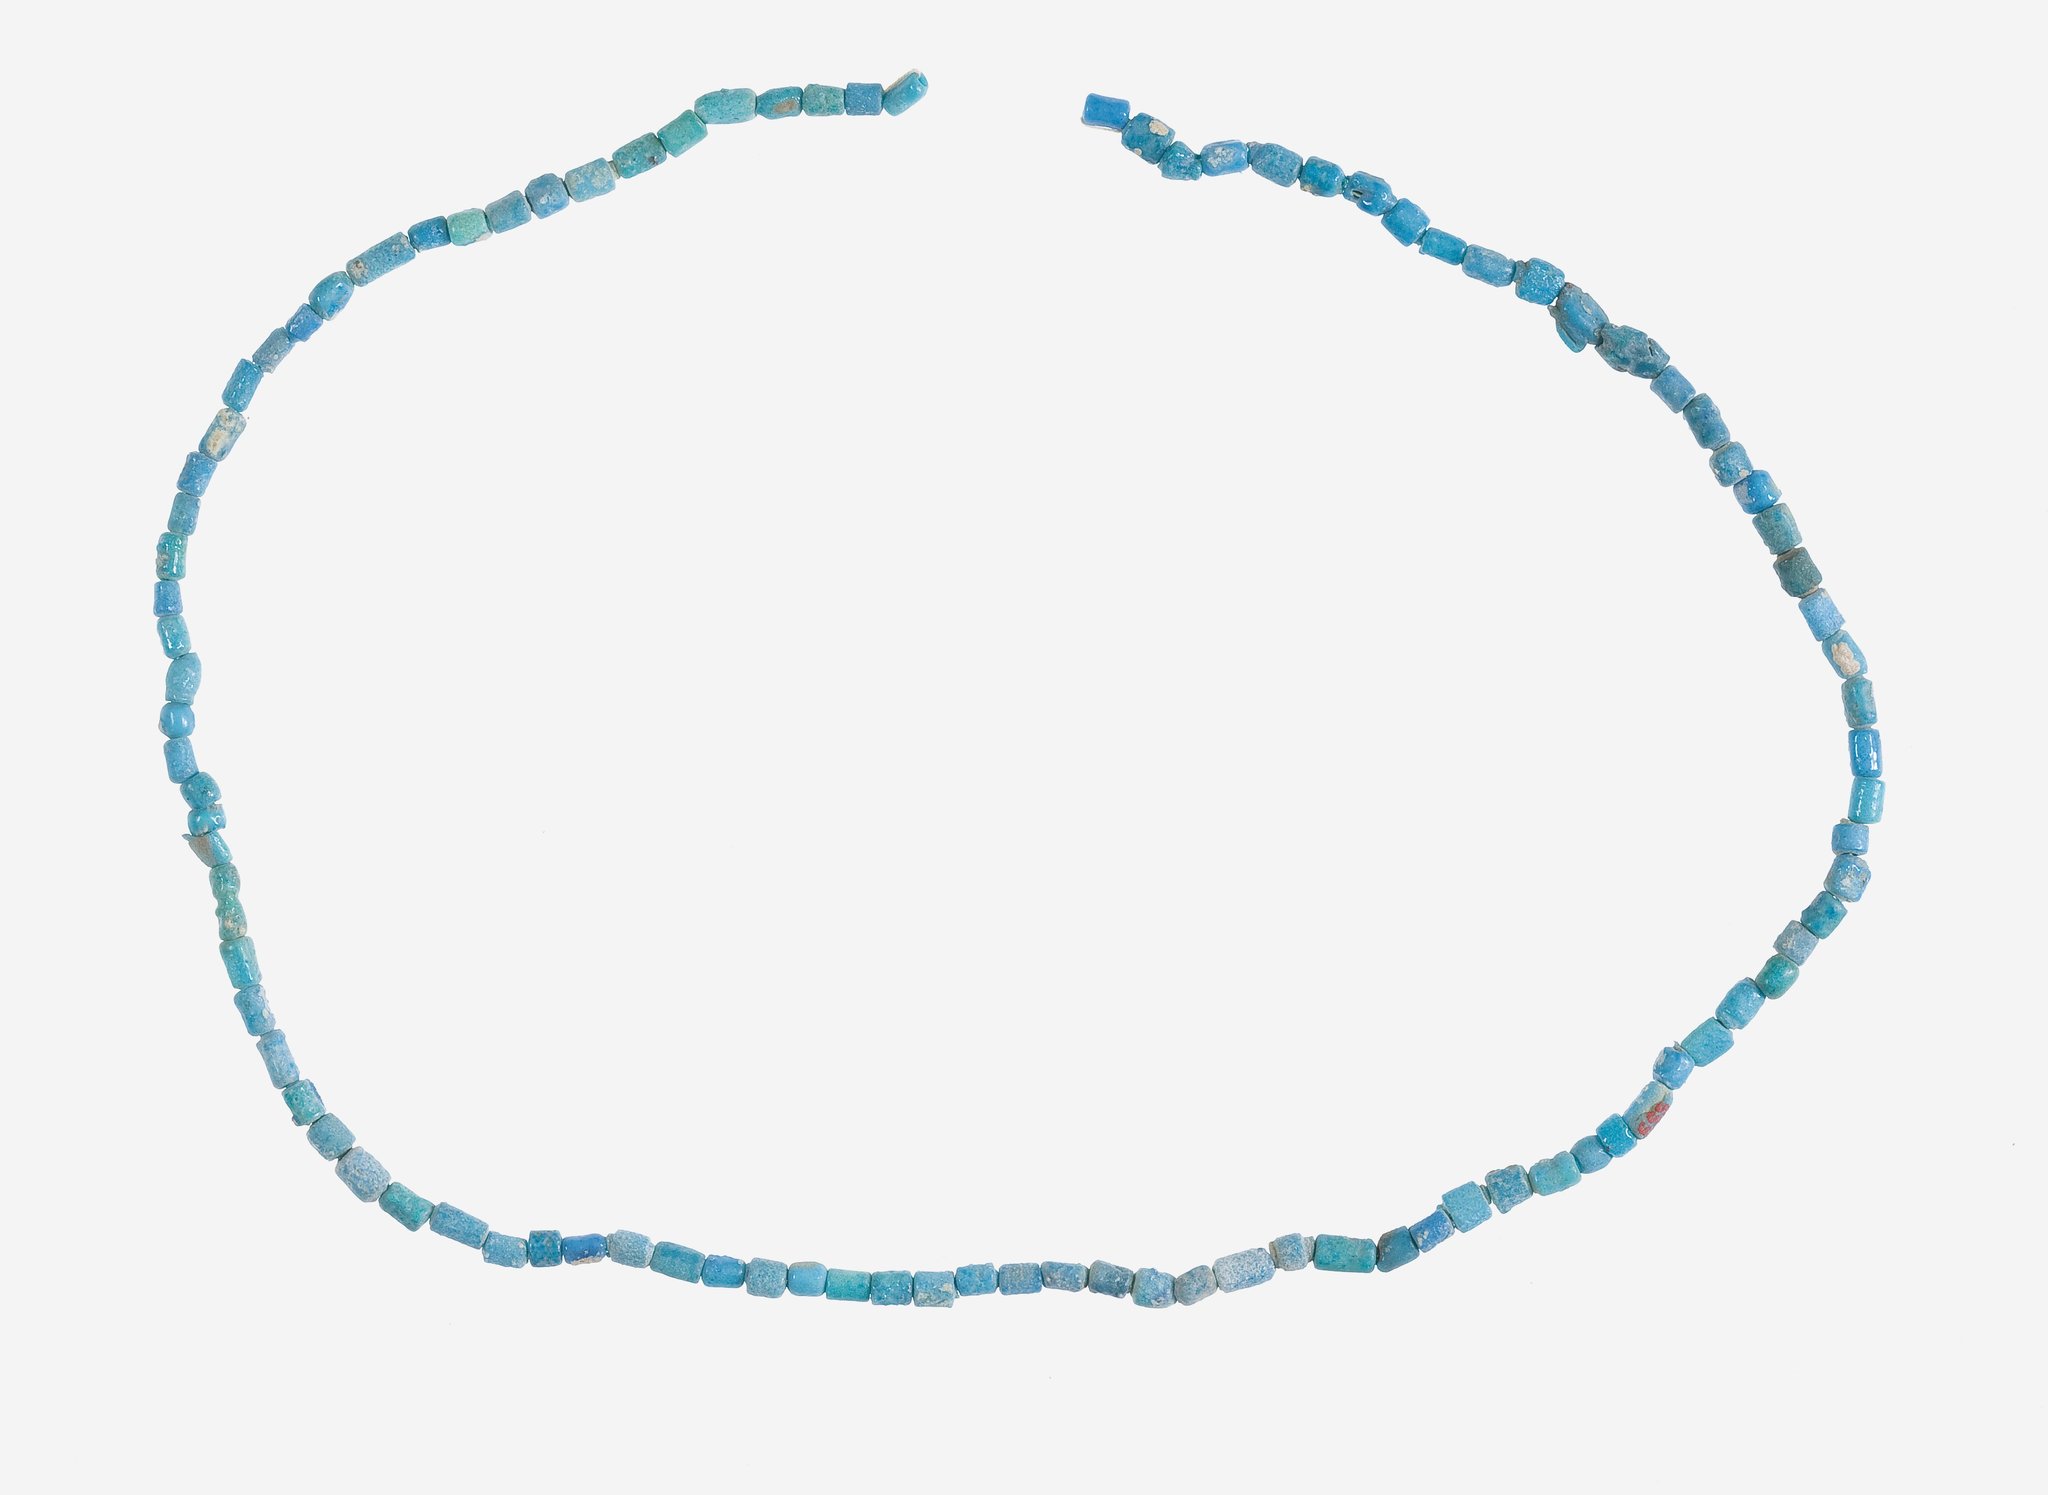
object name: bead, cylinder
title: String of Short Cylindrical Beads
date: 1390-1352 BCE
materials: faience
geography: egypt